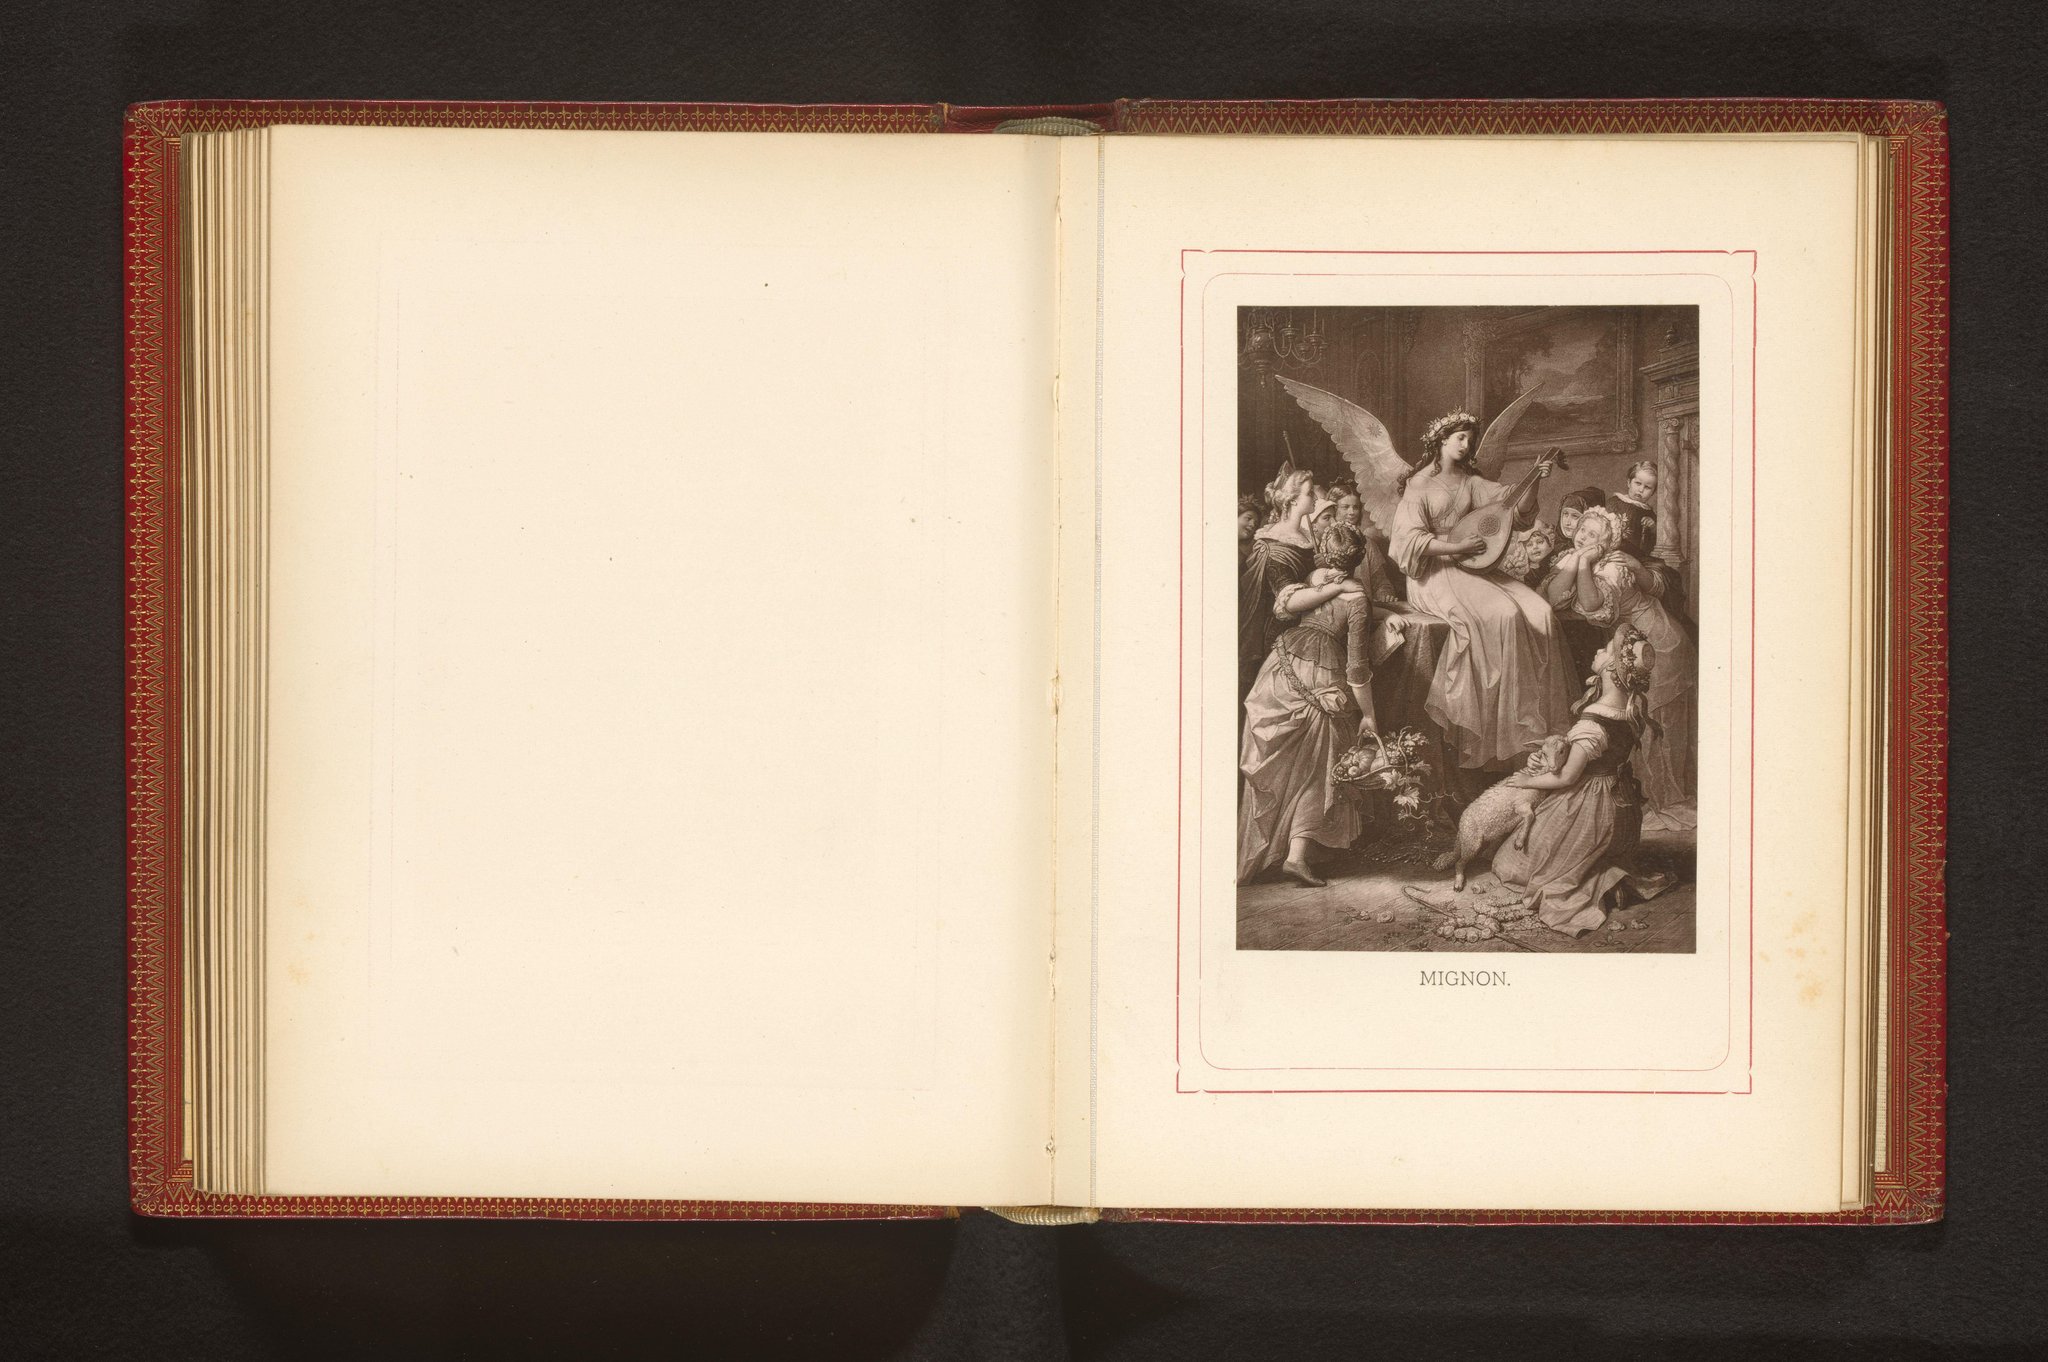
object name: page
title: Fotoreproductie van een tekening, voorstellende een zingende engel met een luit tussen kinderen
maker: Anonymous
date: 1875-1885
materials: paper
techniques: photograph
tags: child, lute, and special forms of lute, e.g.: theorbo, angels